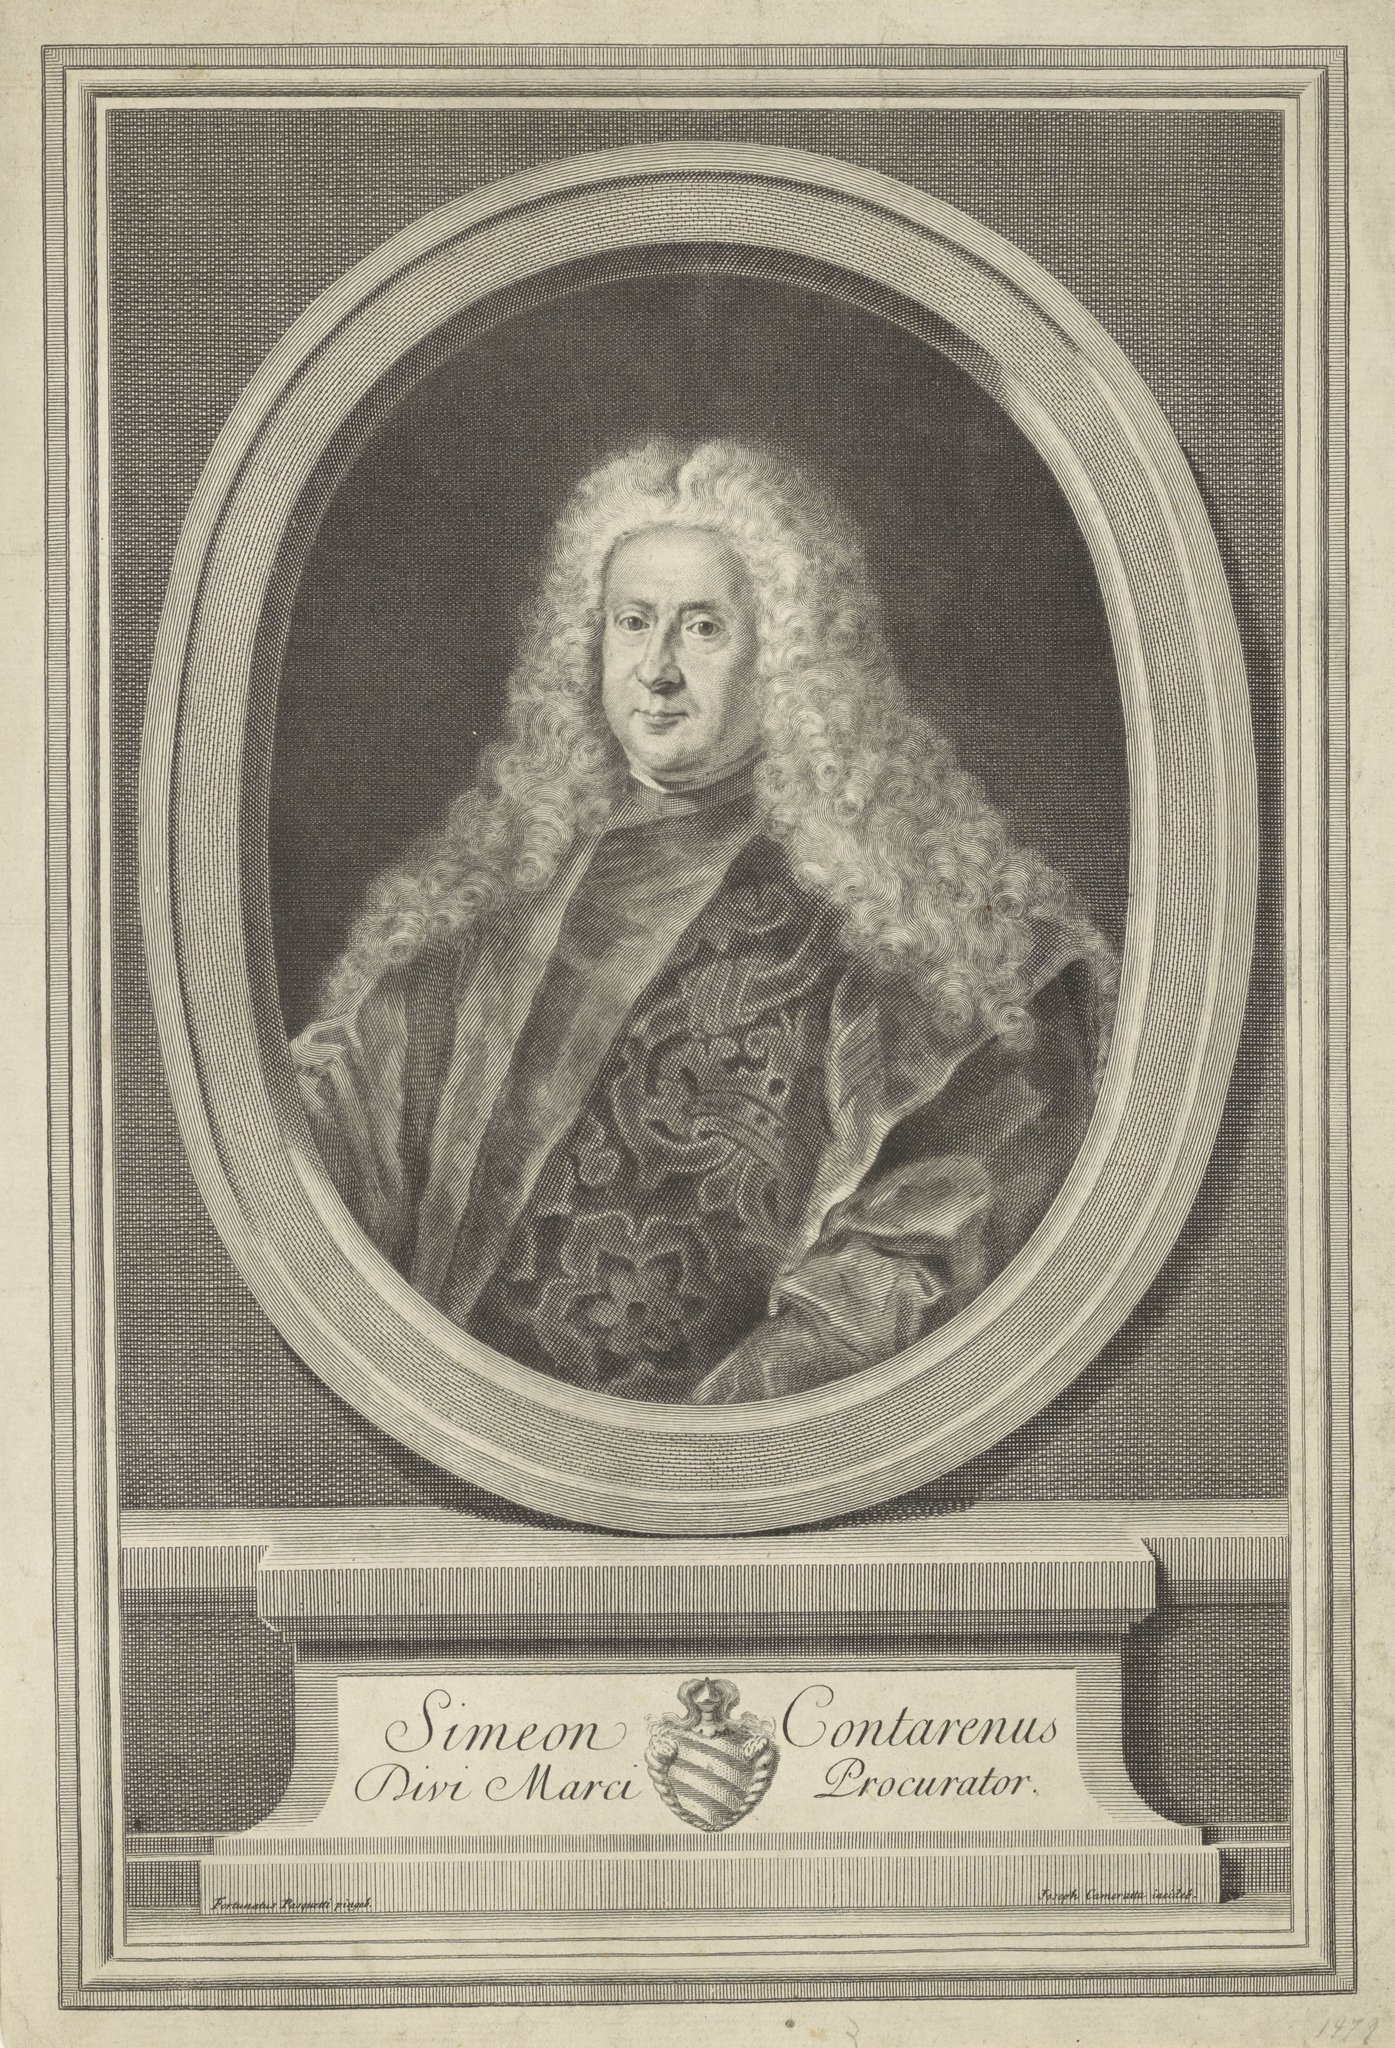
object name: print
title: Portret van Simone Contarini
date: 1728-1803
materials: paper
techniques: engraving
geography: italy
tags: venice, simone contarini, historical persons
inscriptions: collector's mark: Lugt 2228